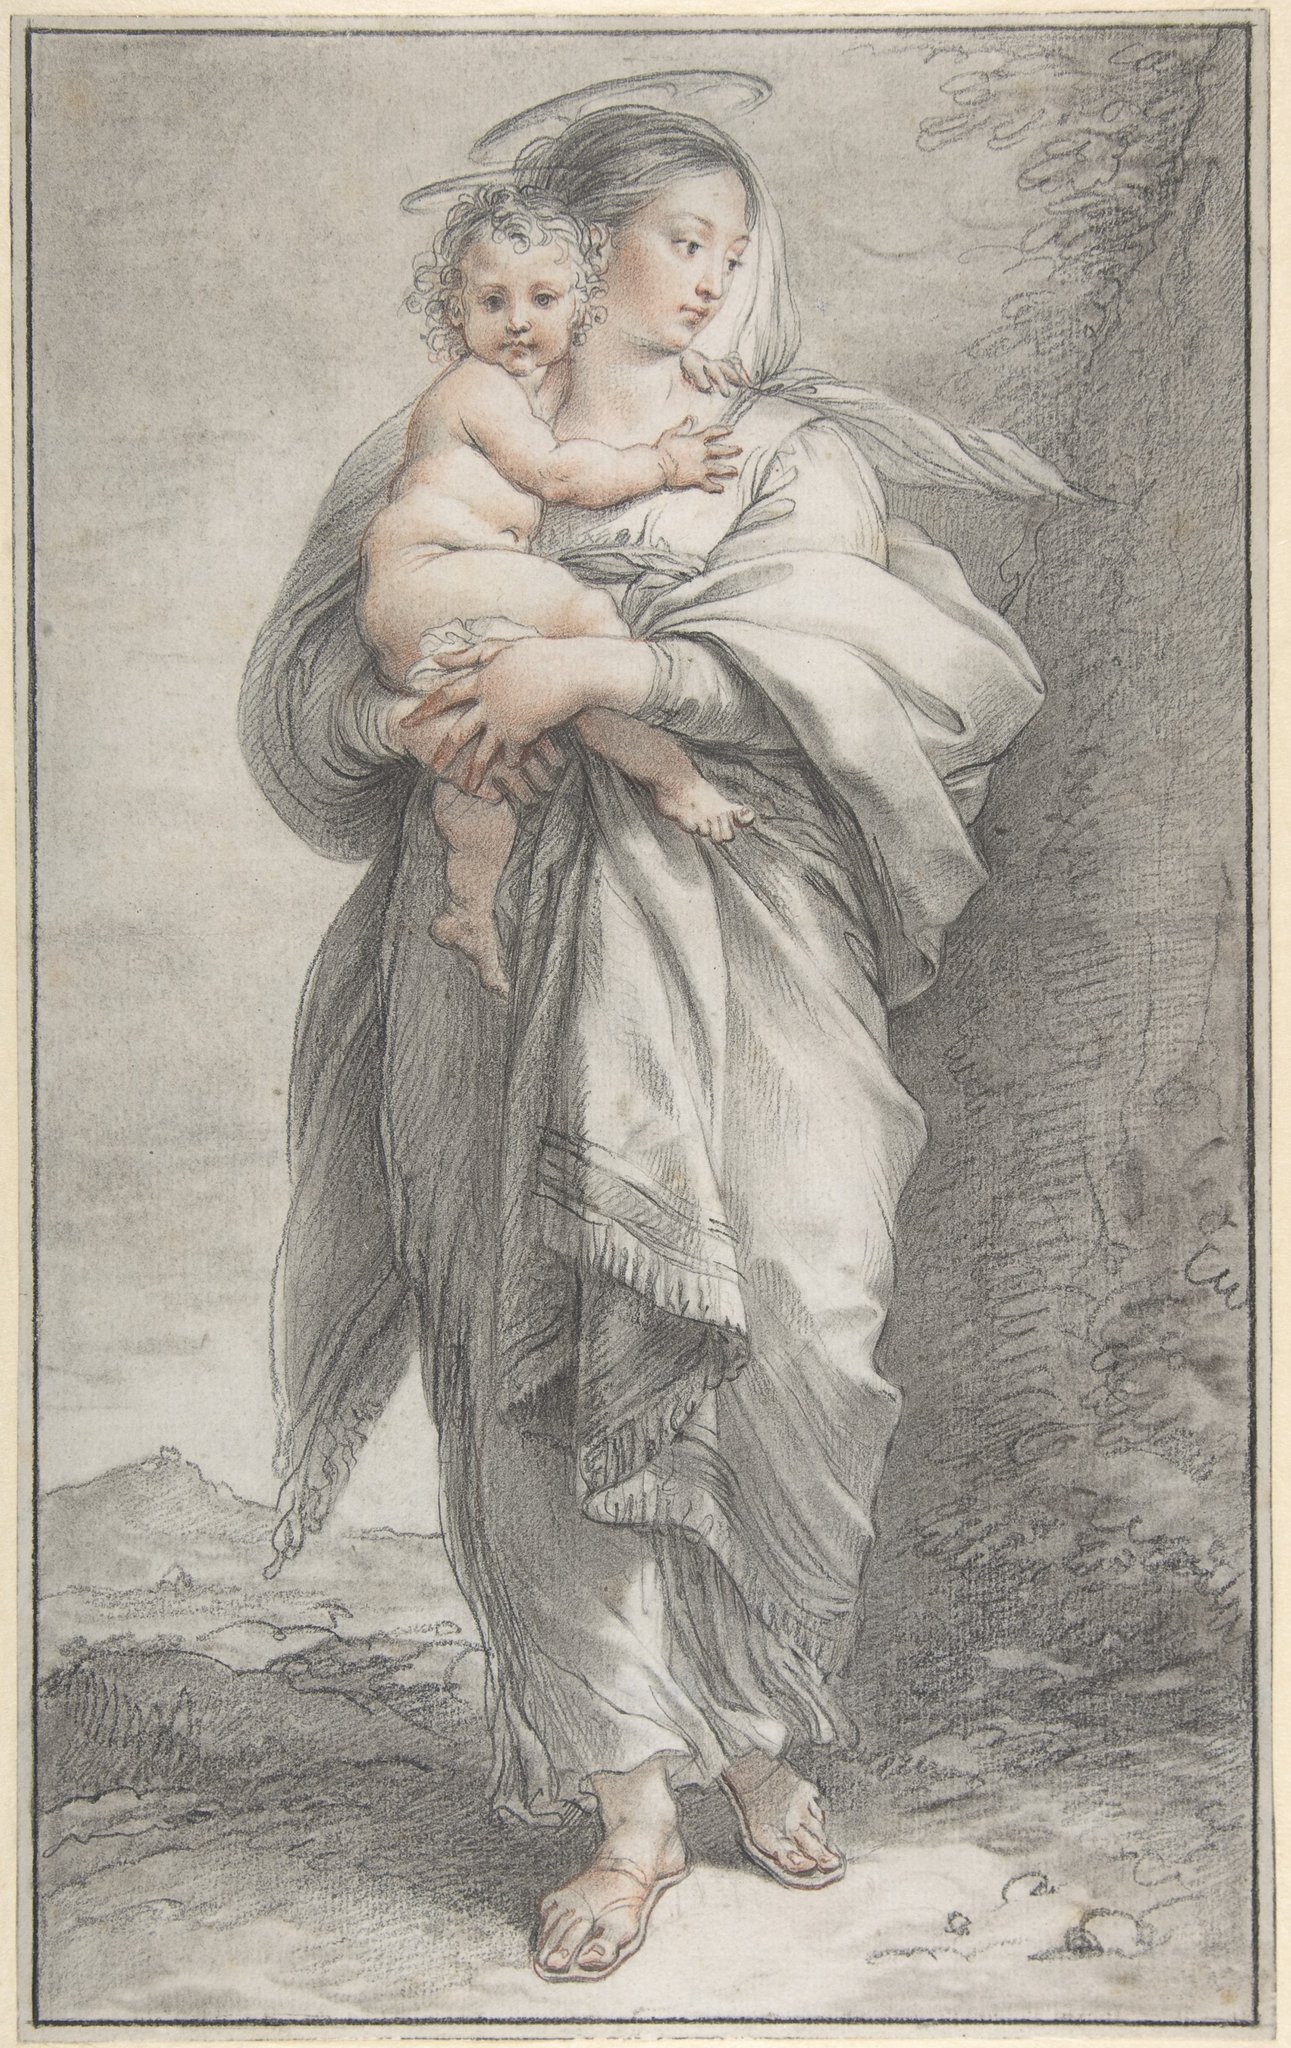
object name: drawing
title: Virgin and Child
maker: giuseppe cades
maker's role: artist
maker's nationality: italian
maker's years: 1750-1799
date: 1750-1799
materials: chalk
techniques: stumping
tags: madonna and child